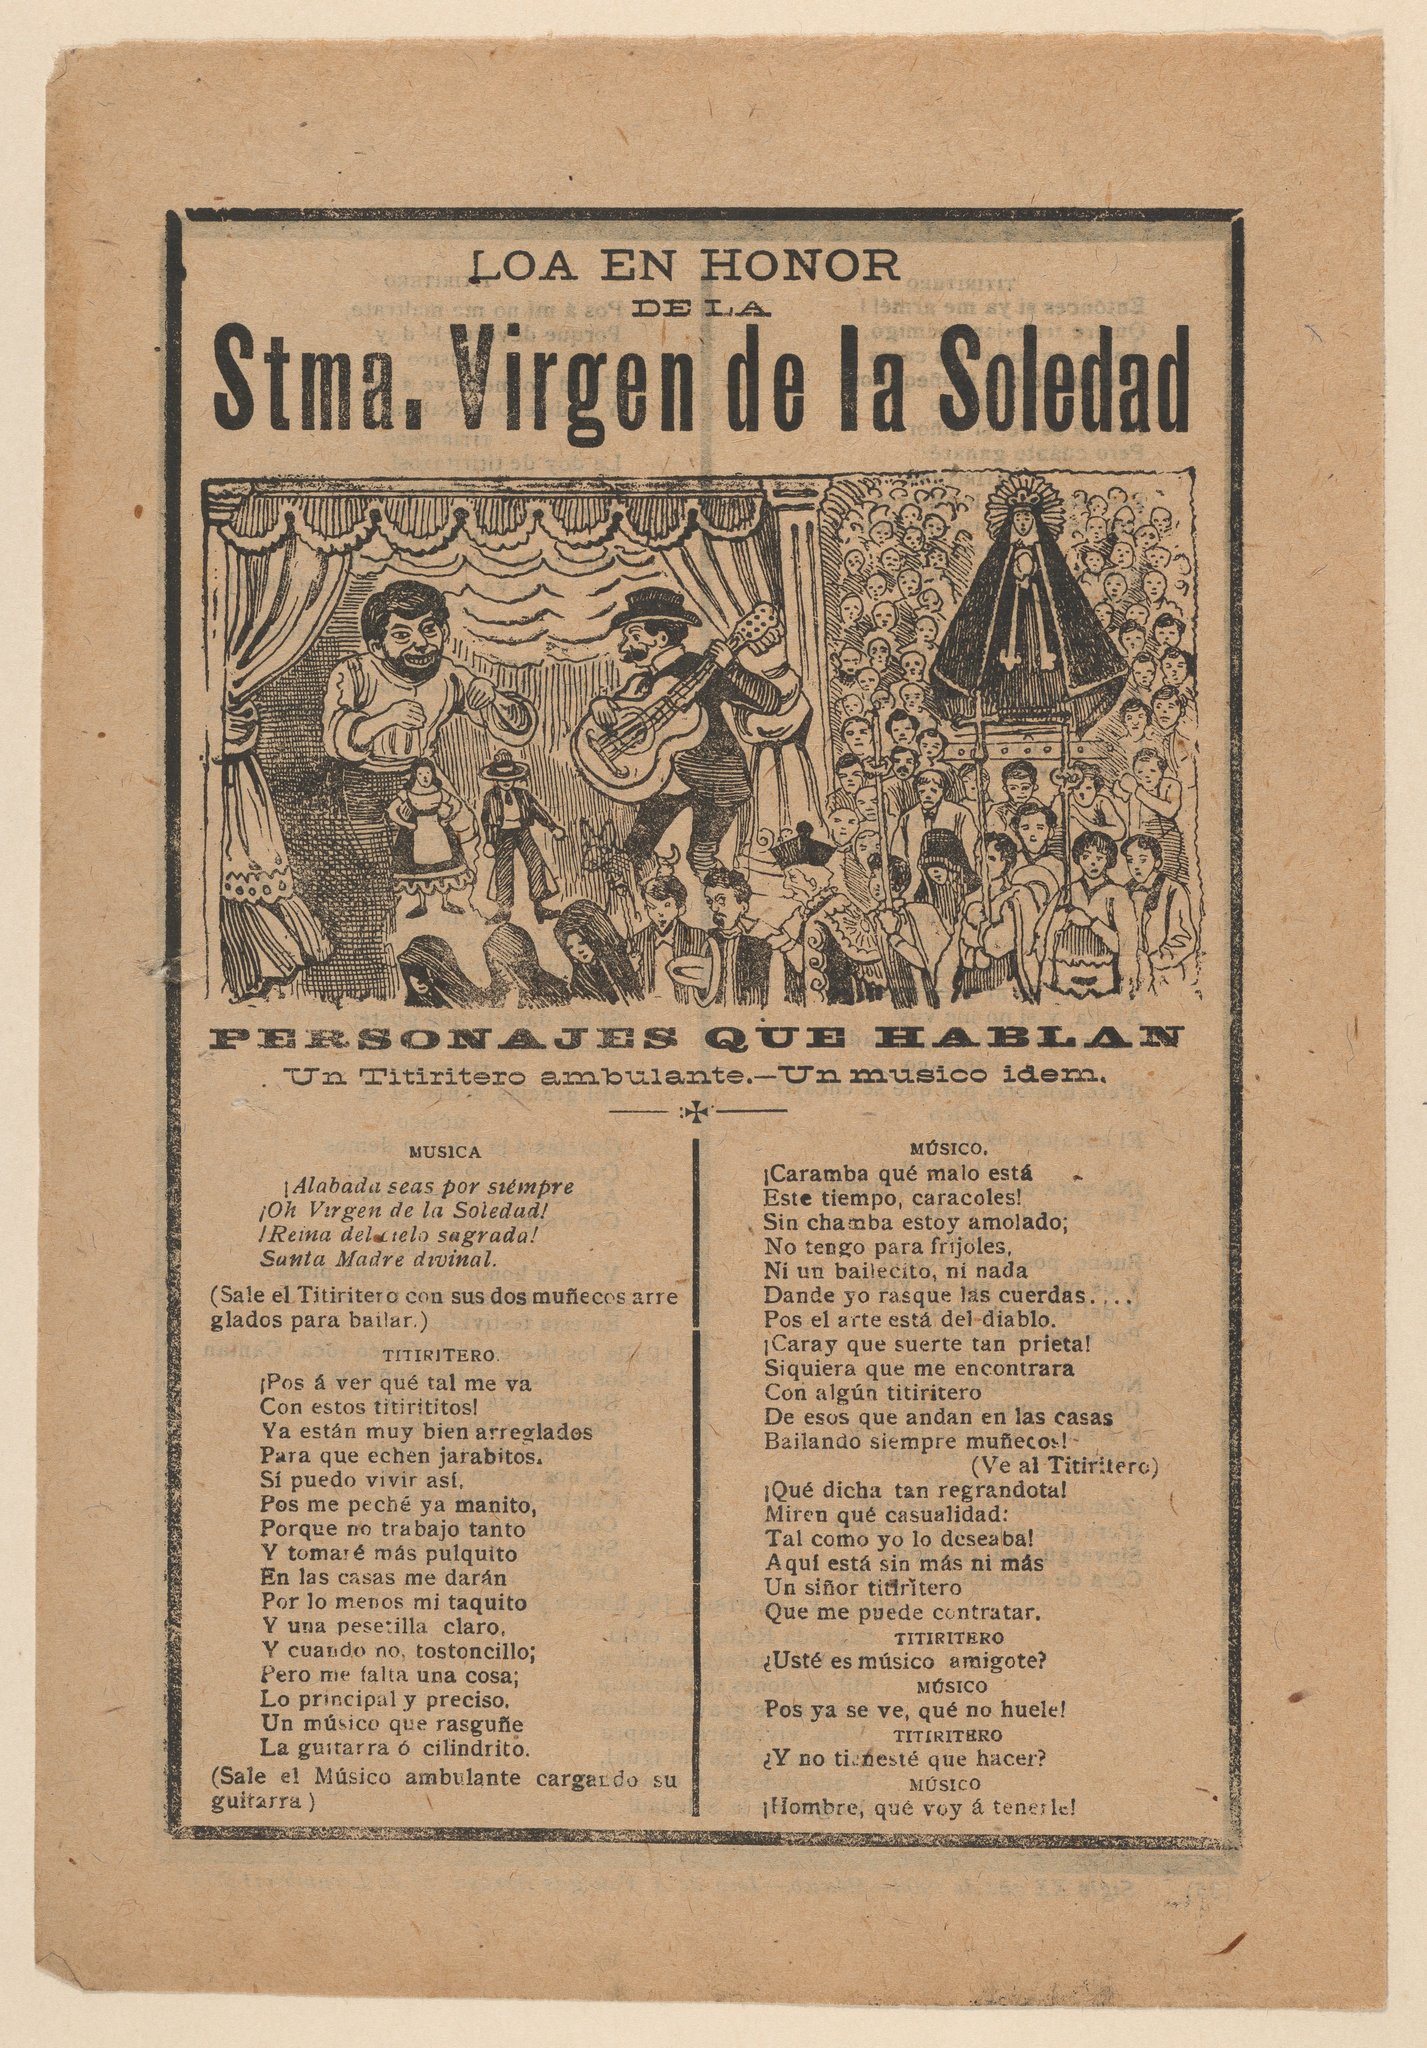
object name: print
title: Broadsheet with a song in honour of the Holy Virgin of Solitude (Stma. Virgen de la Soledad)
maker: josé guadalupe posada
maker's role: artist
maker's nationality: mexican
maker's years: 1852-1913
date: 1903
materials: paper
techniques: letterpress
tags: men